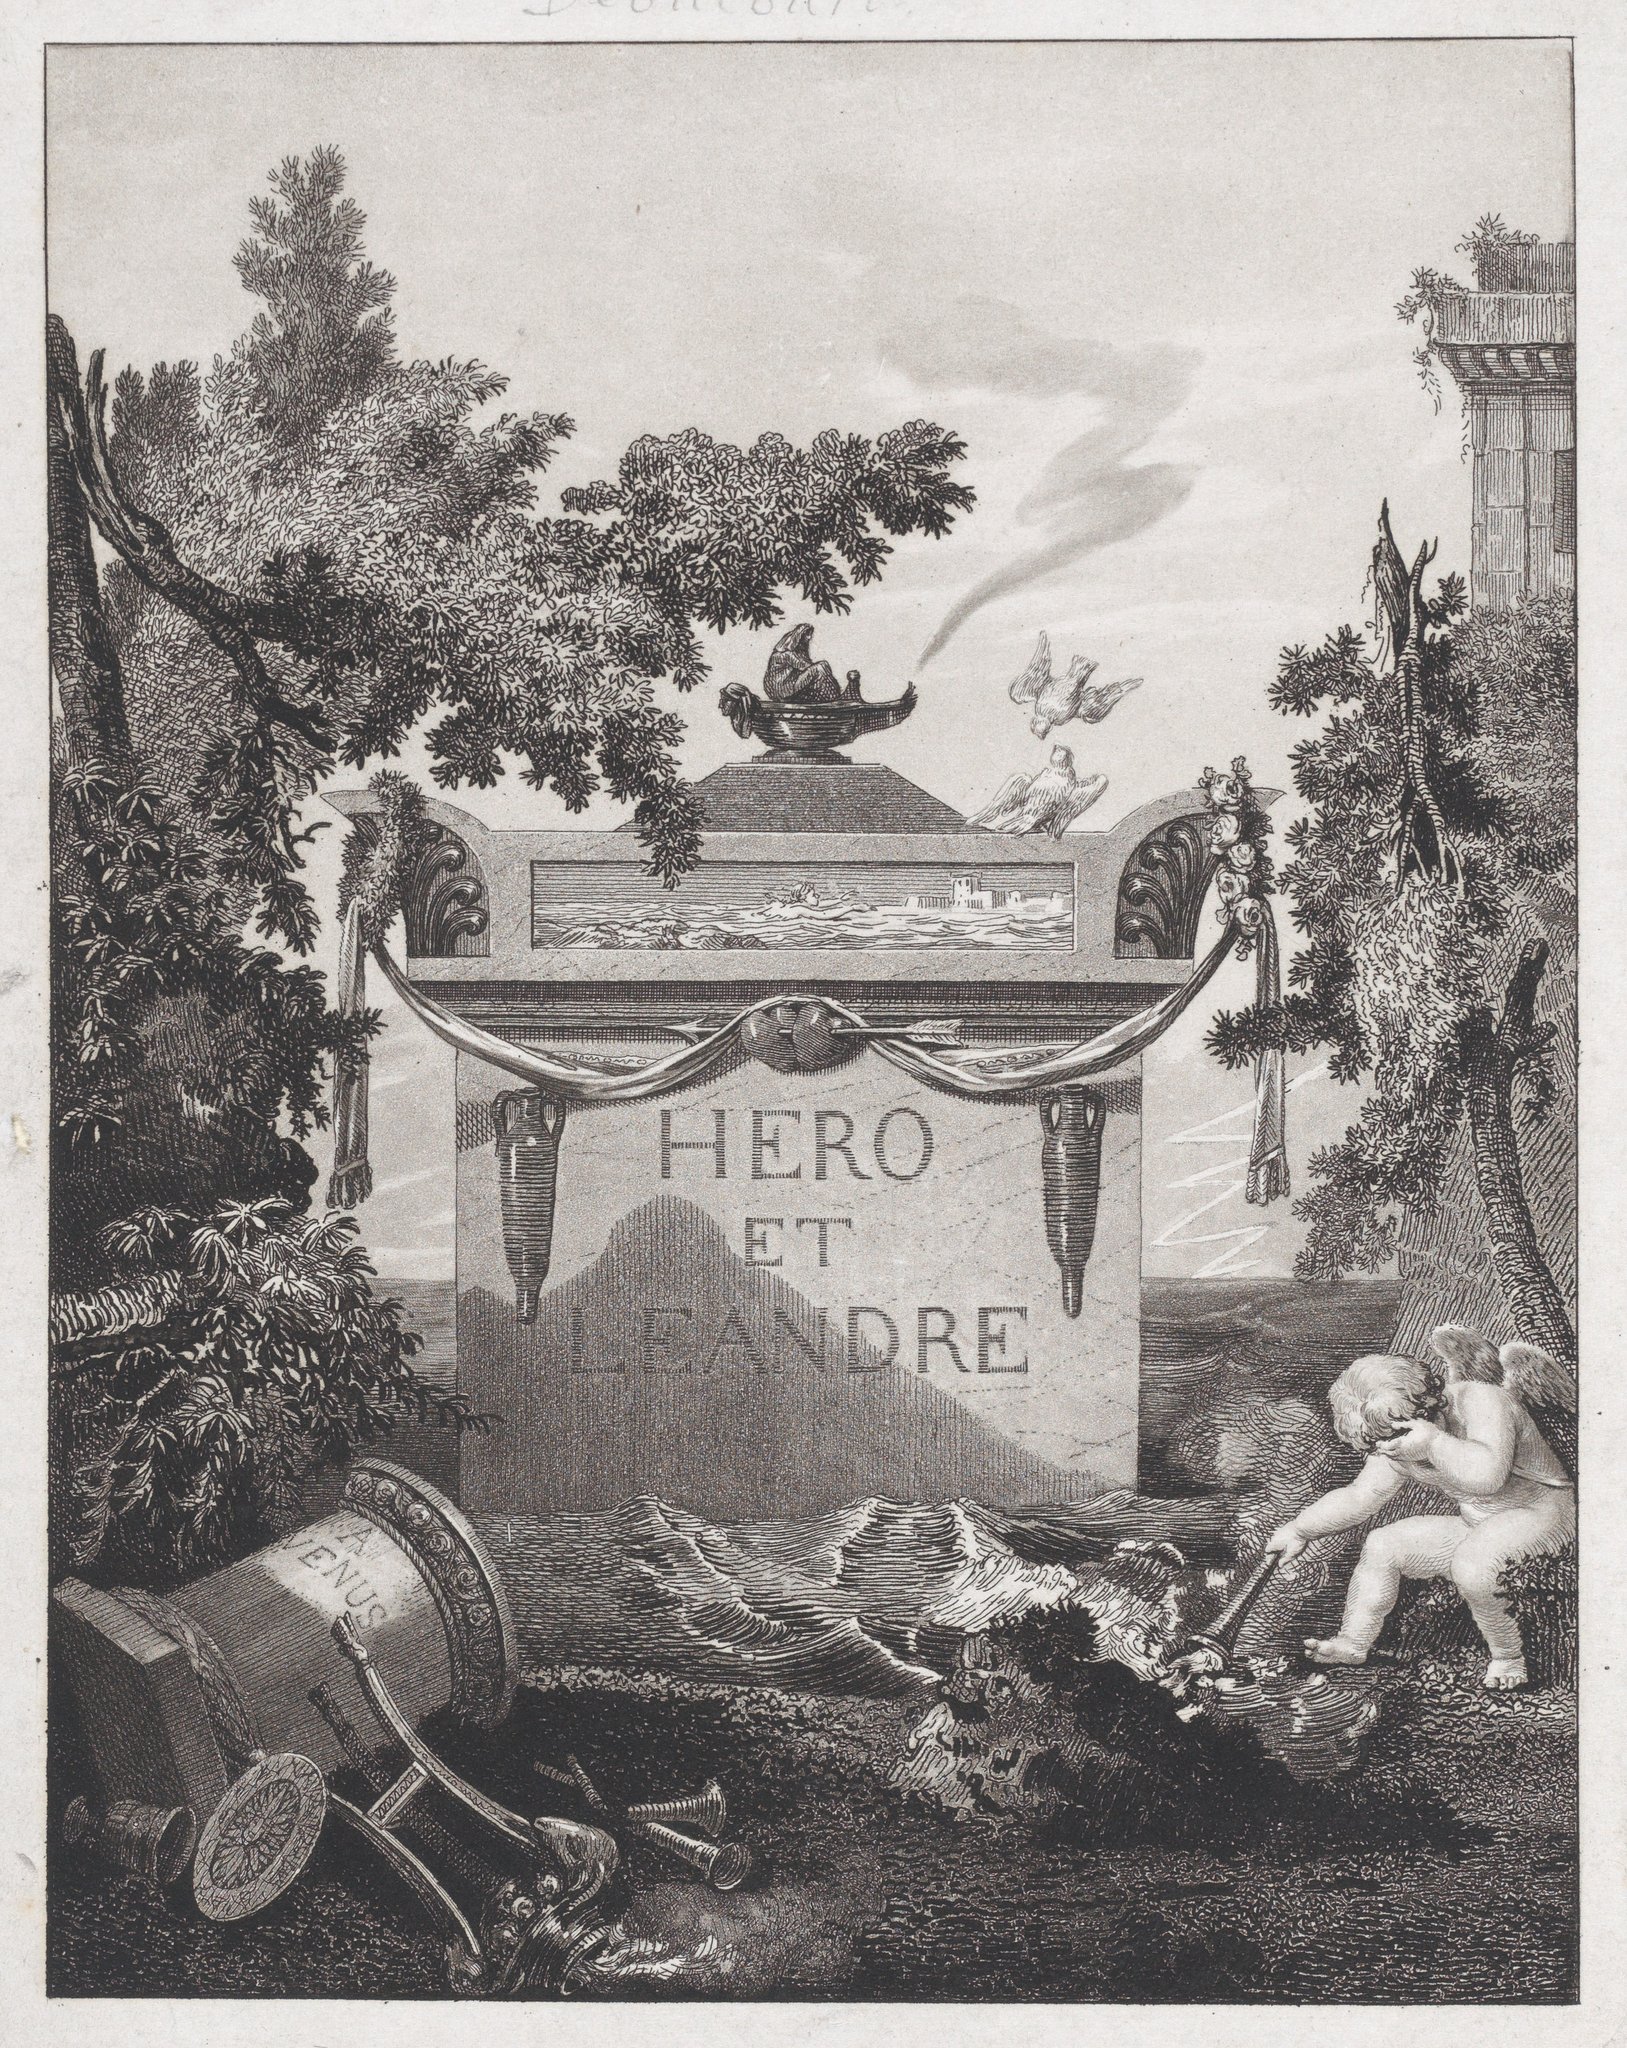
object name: print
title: Frontispiece to "Hero and Leander"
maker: louis philibert debucourt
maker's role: artist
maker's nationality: french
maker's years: 1755-1832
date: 1801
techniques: aquatint, etching